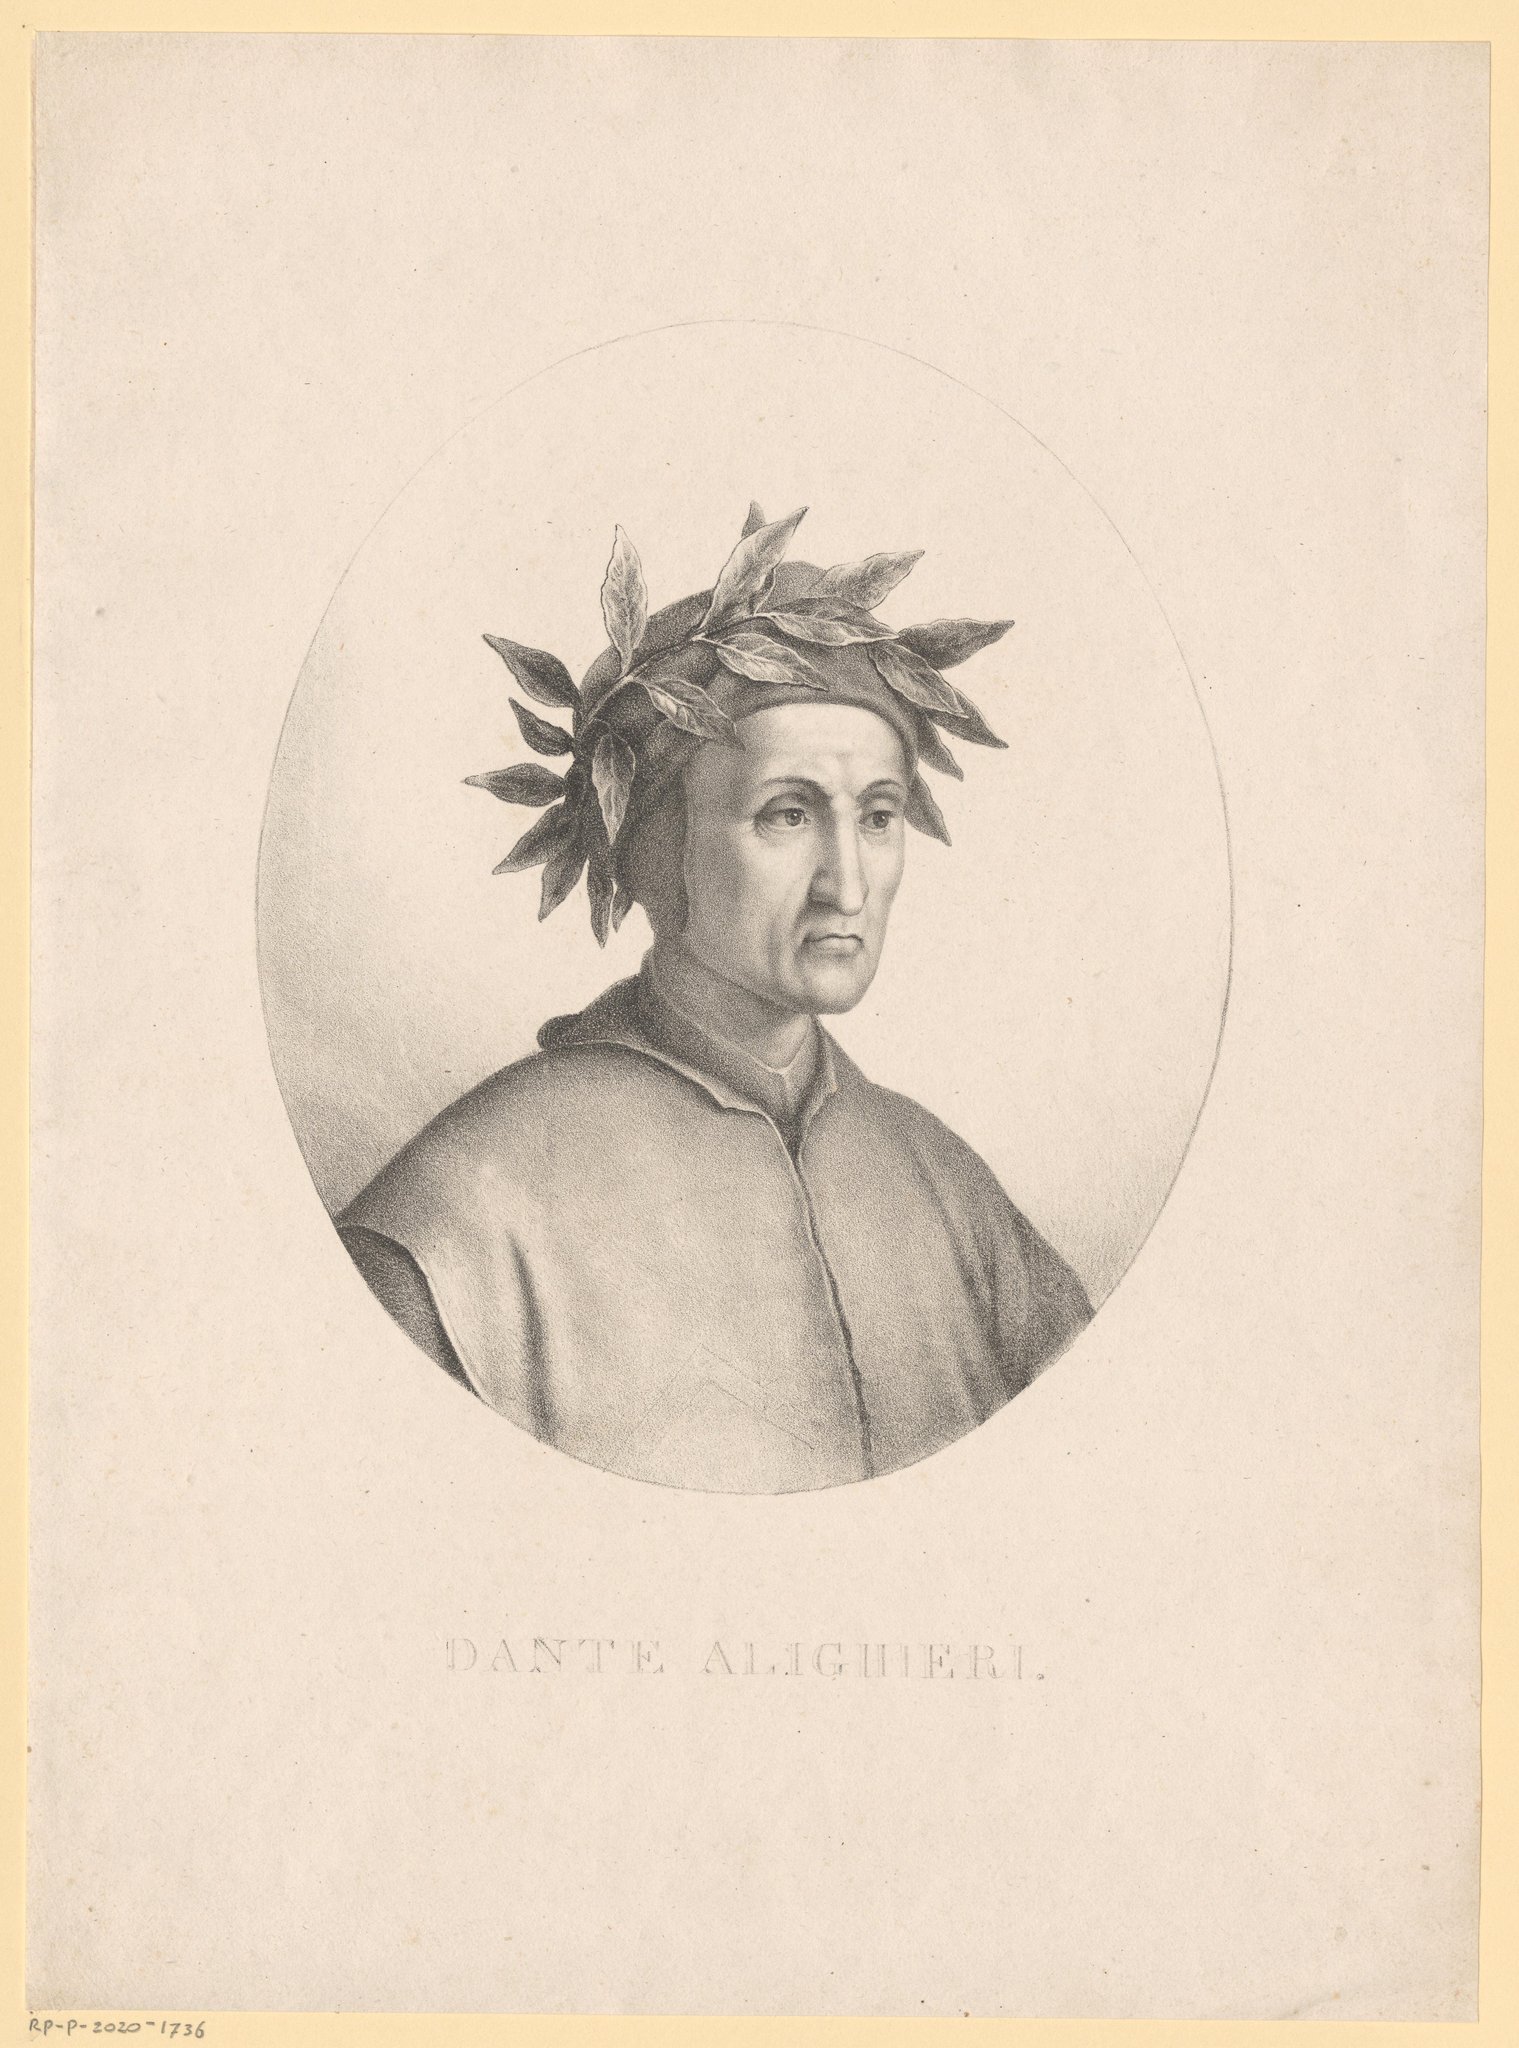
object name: print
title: Portret van Dante Alighieri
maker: Anonymous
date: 1800-1899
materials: paper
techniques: lithograph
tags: dante alighieri, historical persons, portrait of a writer, writer, poet, author